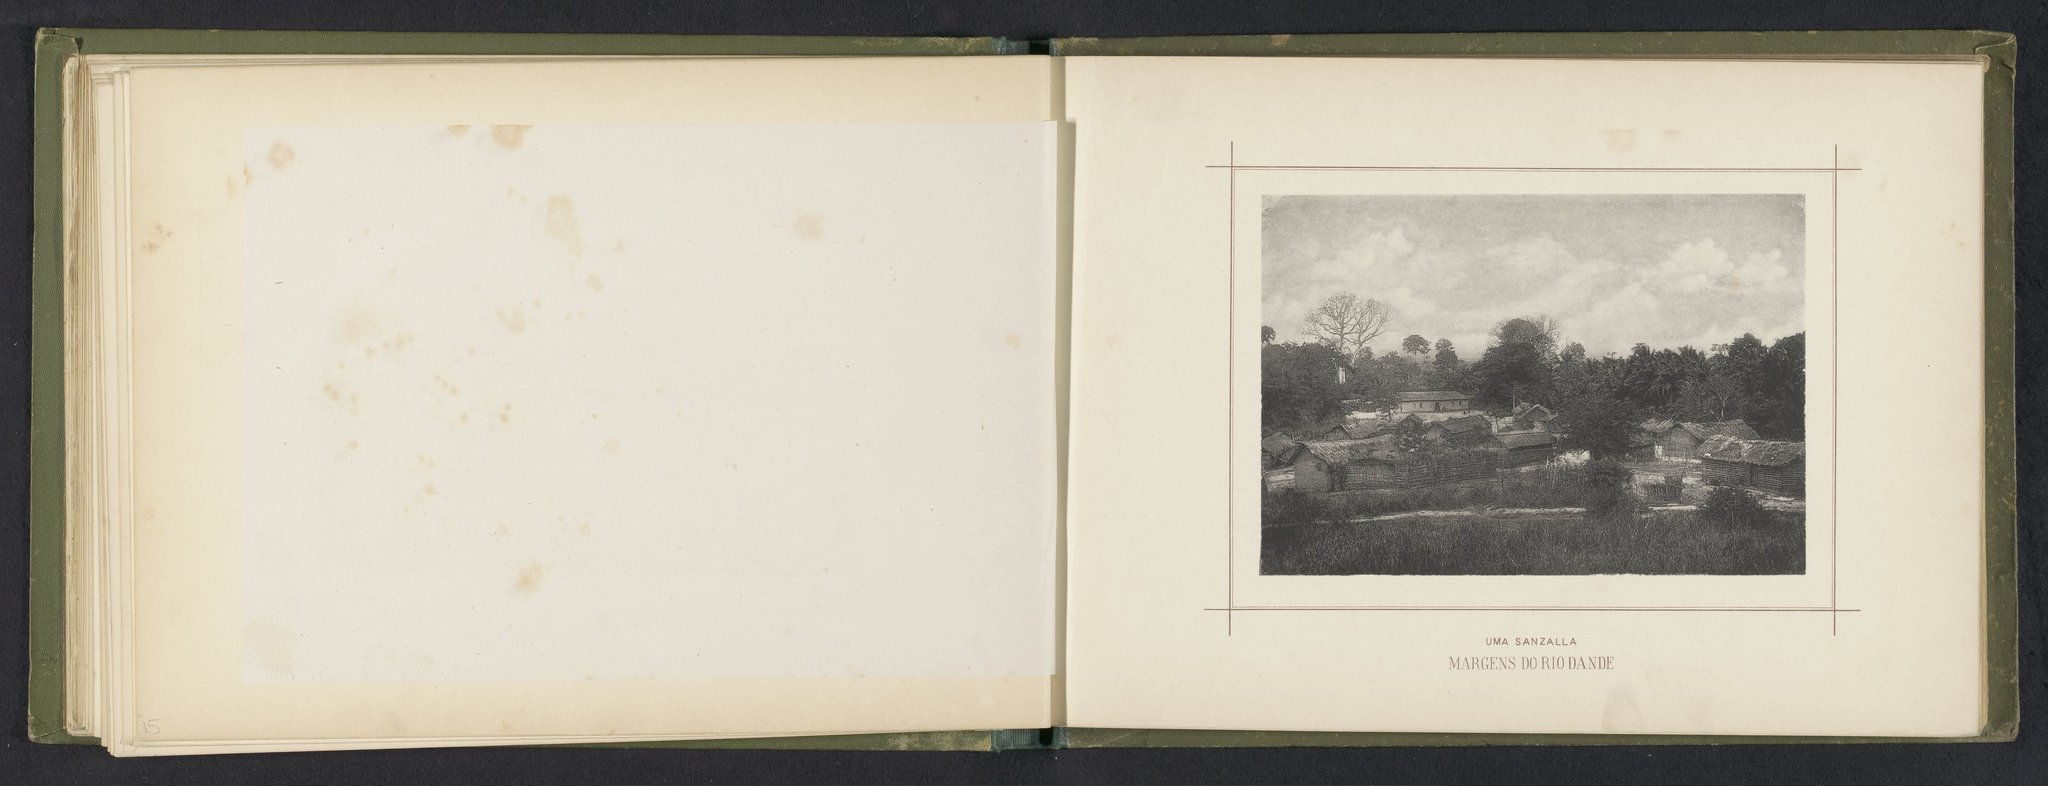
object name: page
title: Uma Sanzalla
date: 1876-1886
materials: paper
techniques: photograph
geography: angola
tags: village, housing